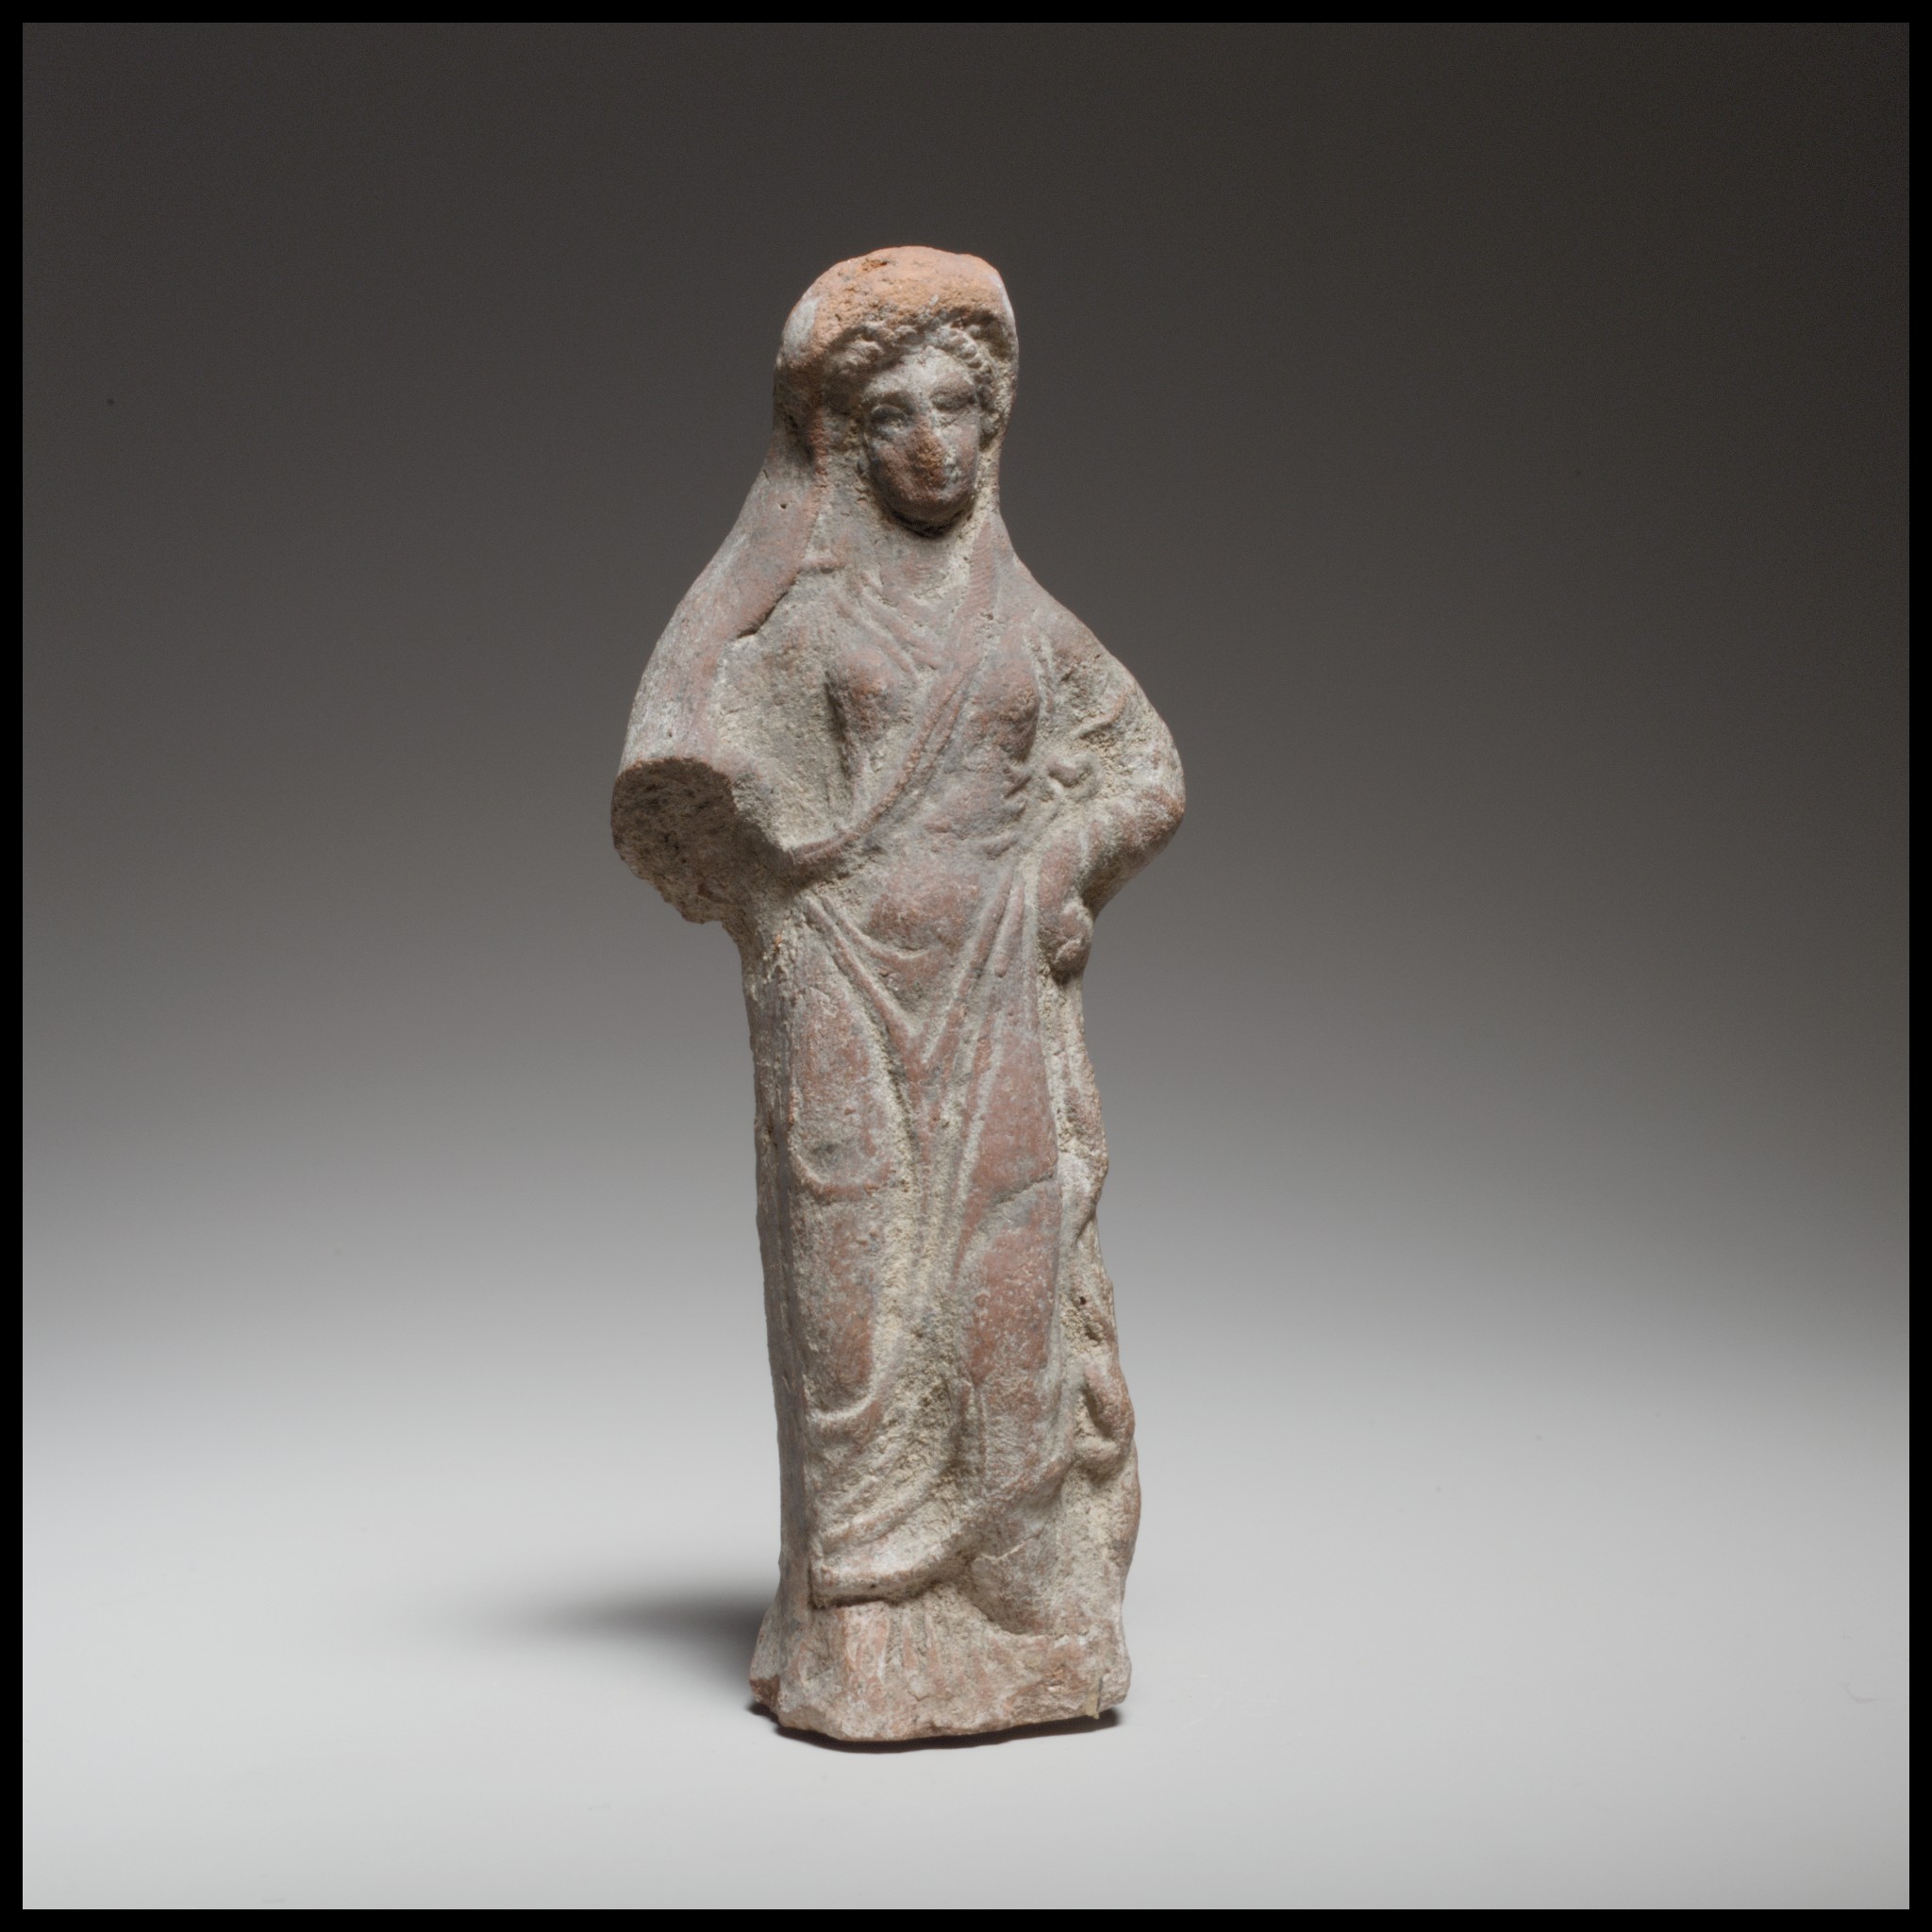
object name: statuette of a woman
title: Terracotta statuette of a woman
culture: cypriot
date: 300-201 BCE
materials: terracotta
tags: women